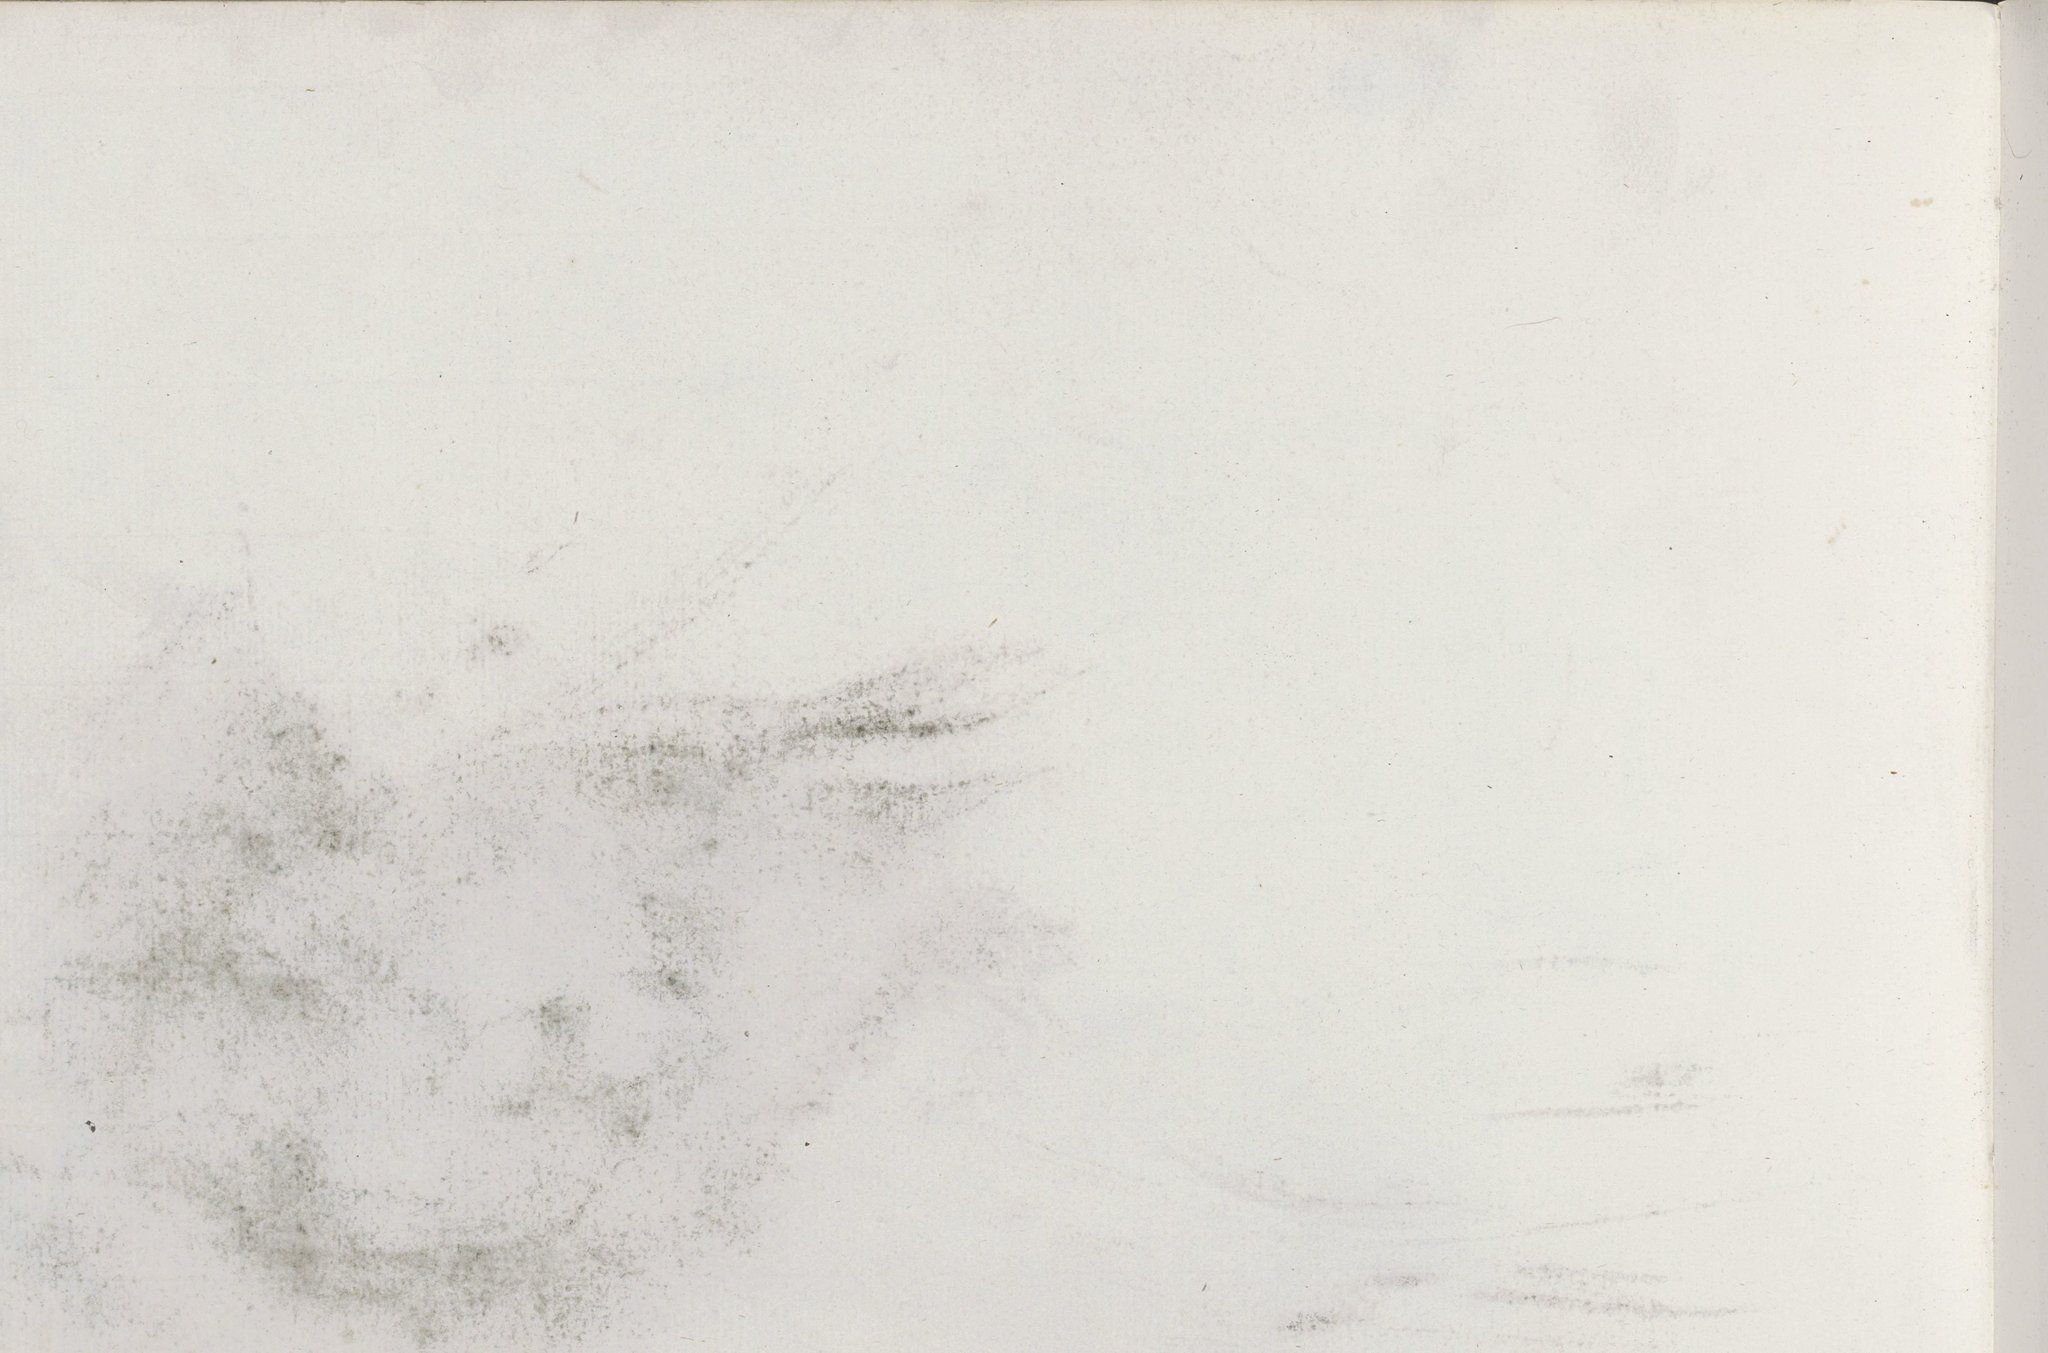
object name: sketchbook leaf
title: Abklatsch van de krijttekening op pagina 7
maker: willem witsen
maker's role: draughtsman, painter, print maker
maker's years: 1860-1923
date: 1887-1892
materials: chalk, paper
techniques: stumping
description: Pagina 6 uit een schetsboek met 17 bladen.